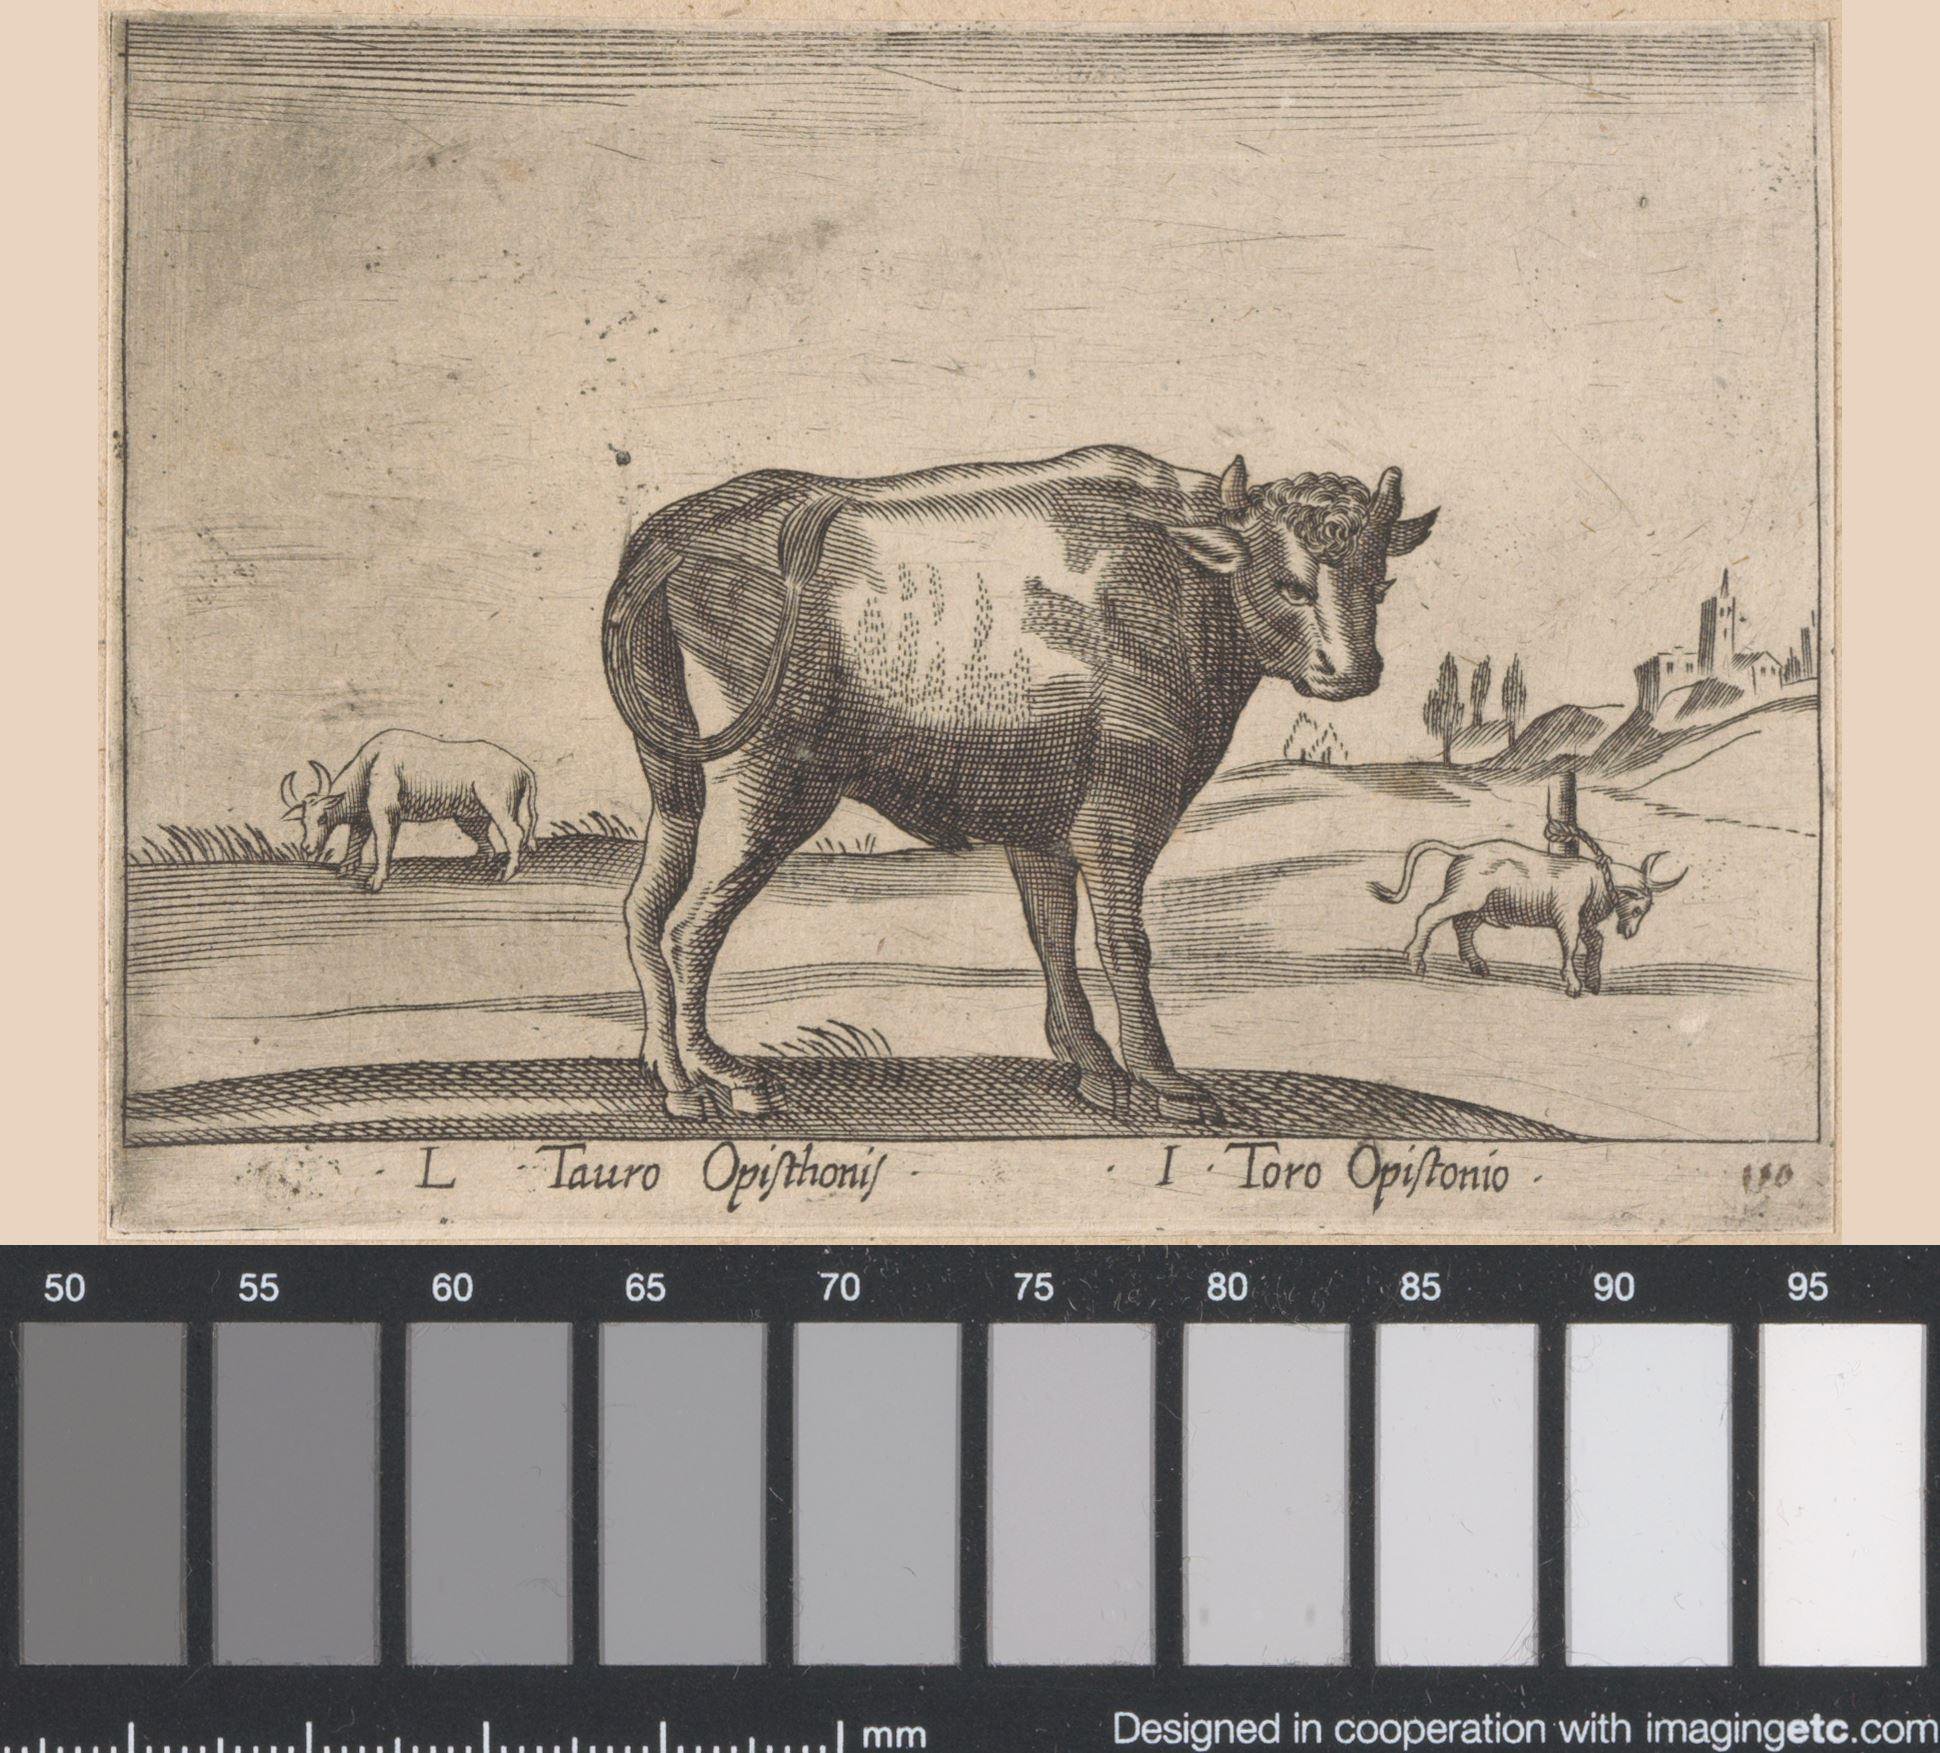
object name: print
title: Dieren en fabelwezens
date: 1565-1630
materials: paper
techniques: etching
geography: italy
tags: bull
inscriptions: collector's mark: Lugt 11, number: ‘110’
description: Deze prent maakt deel uit van een reeks prenten van dieren door Antonio Tempesta. Bekend is dat een tweede staat (met nummering) van deze serie is uitgegeven door Giovanni Giacomo de' Rossi in 1650. Onbekend is wie de eerste staat heeft uitgegeven en wanneer.